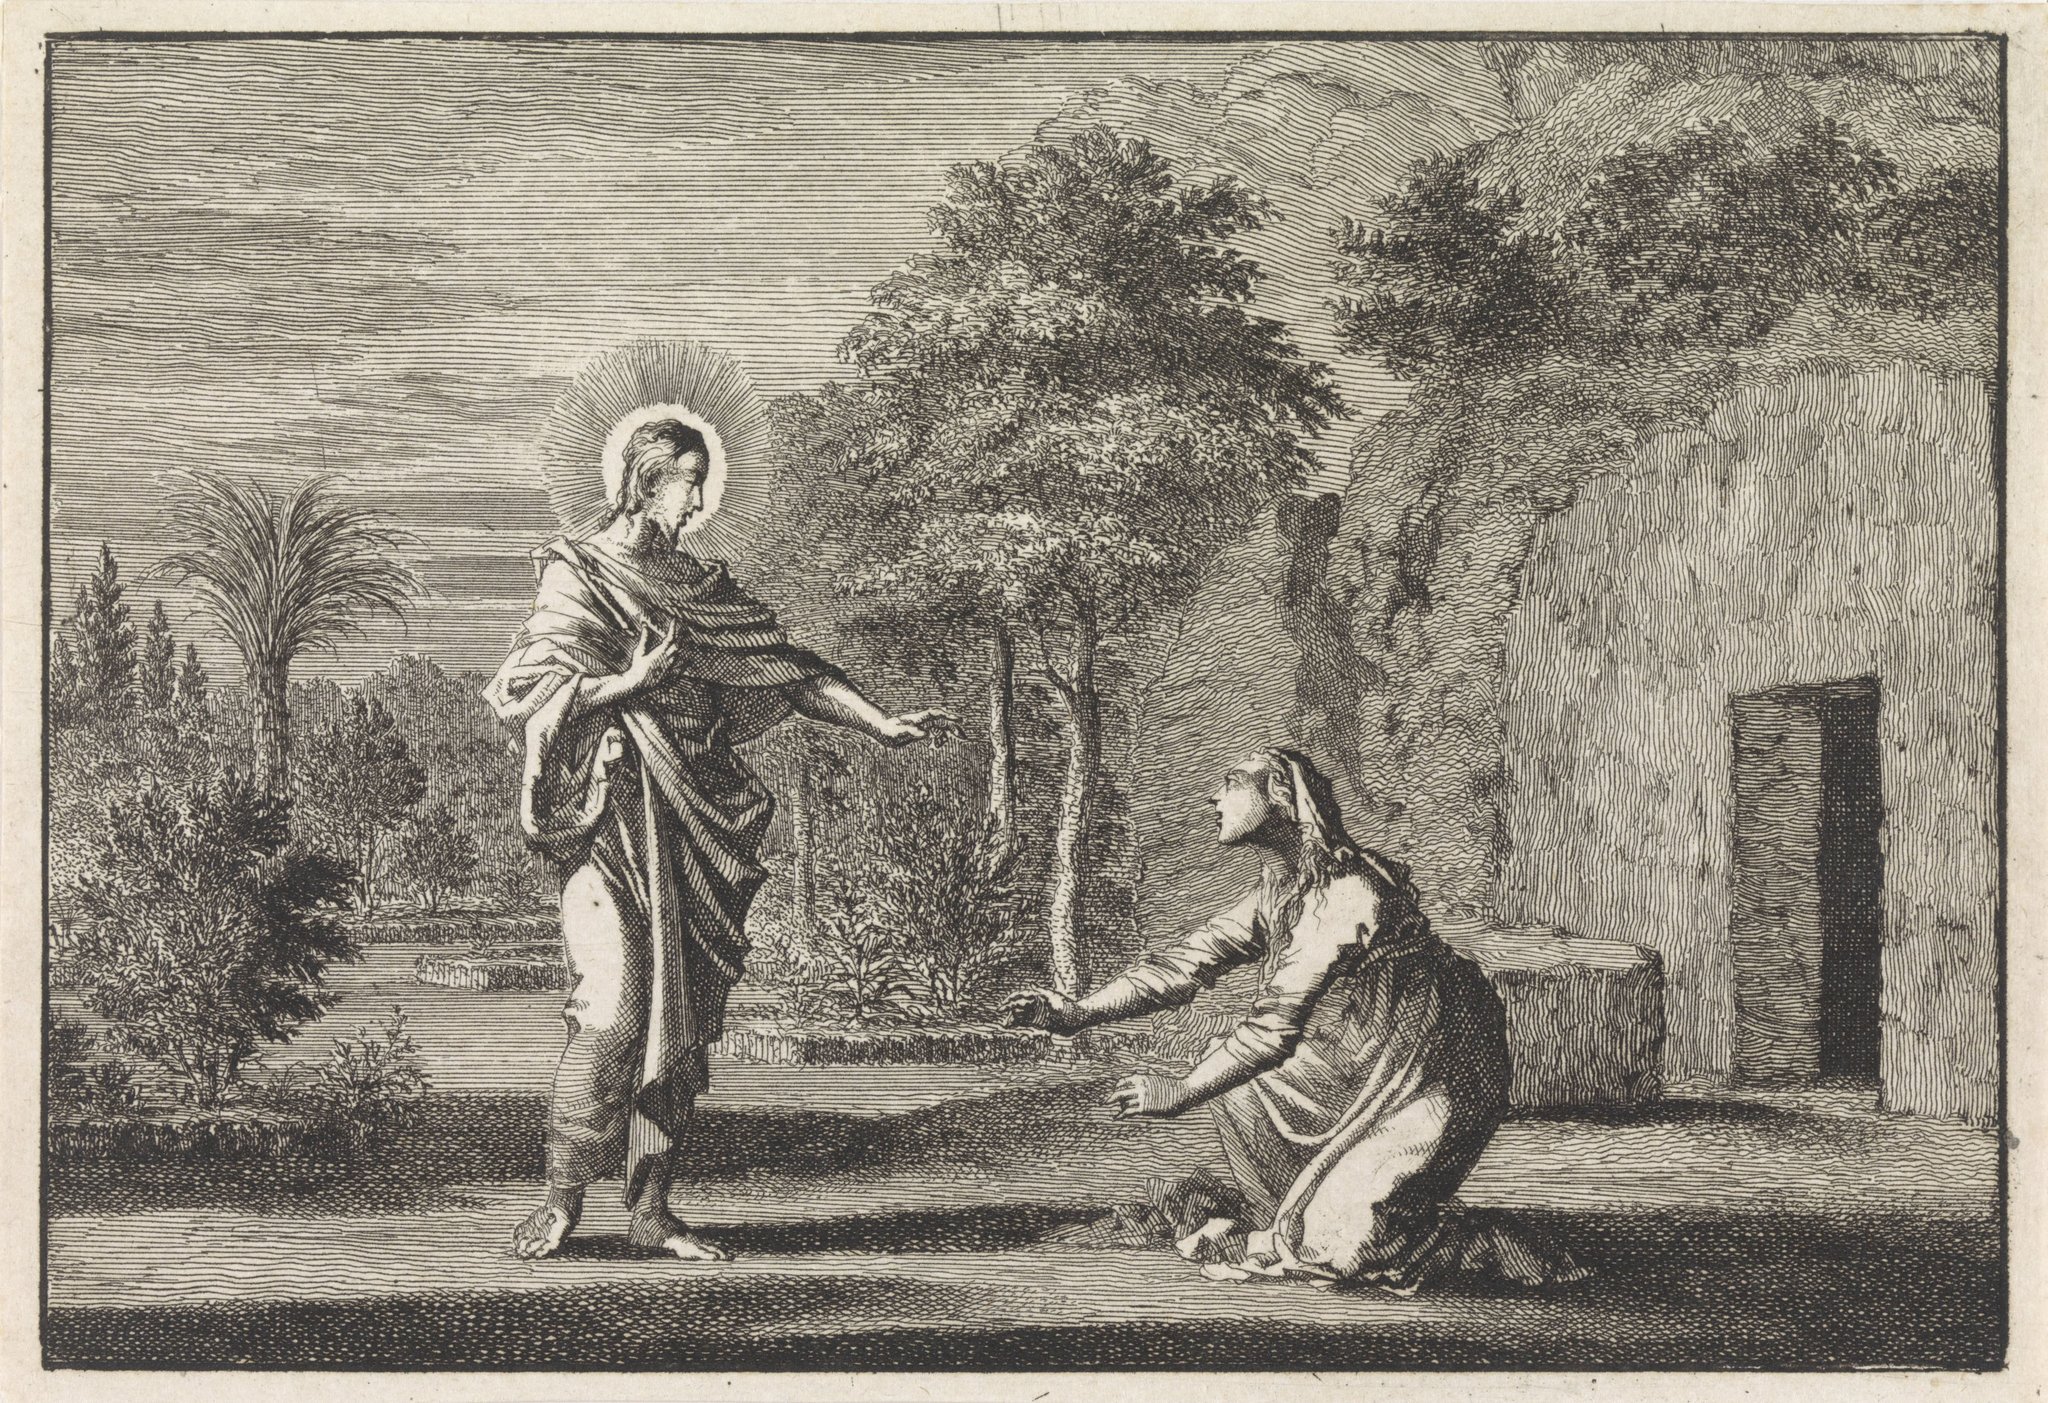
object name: print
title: Christus verschijnt aan Maria Magdalena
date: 1703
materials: paper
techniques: etching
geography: amsterdam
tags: mary magdalene kneeling before christ, who is usually represented as a gardener with a hoe and/or a spade; 'noli me tangere'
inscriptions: collector's mark: Lugt 2228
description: Proefdruk van een boekillustratie voor David Martin. Historie des Ouden en Nieuwen Testaments. Amsterdam, Pieter Mortier, 1703. Deel II. De boekillustraties voor de Mortierbijbel hebben verschillende staten en kopieën, waarbij de chronologische volgorde moeilijk te achterhalen valt. Als boekillustraties werden ze bovendien herhaaldelijk opnieuw gebruikt voor andere boekwerken.